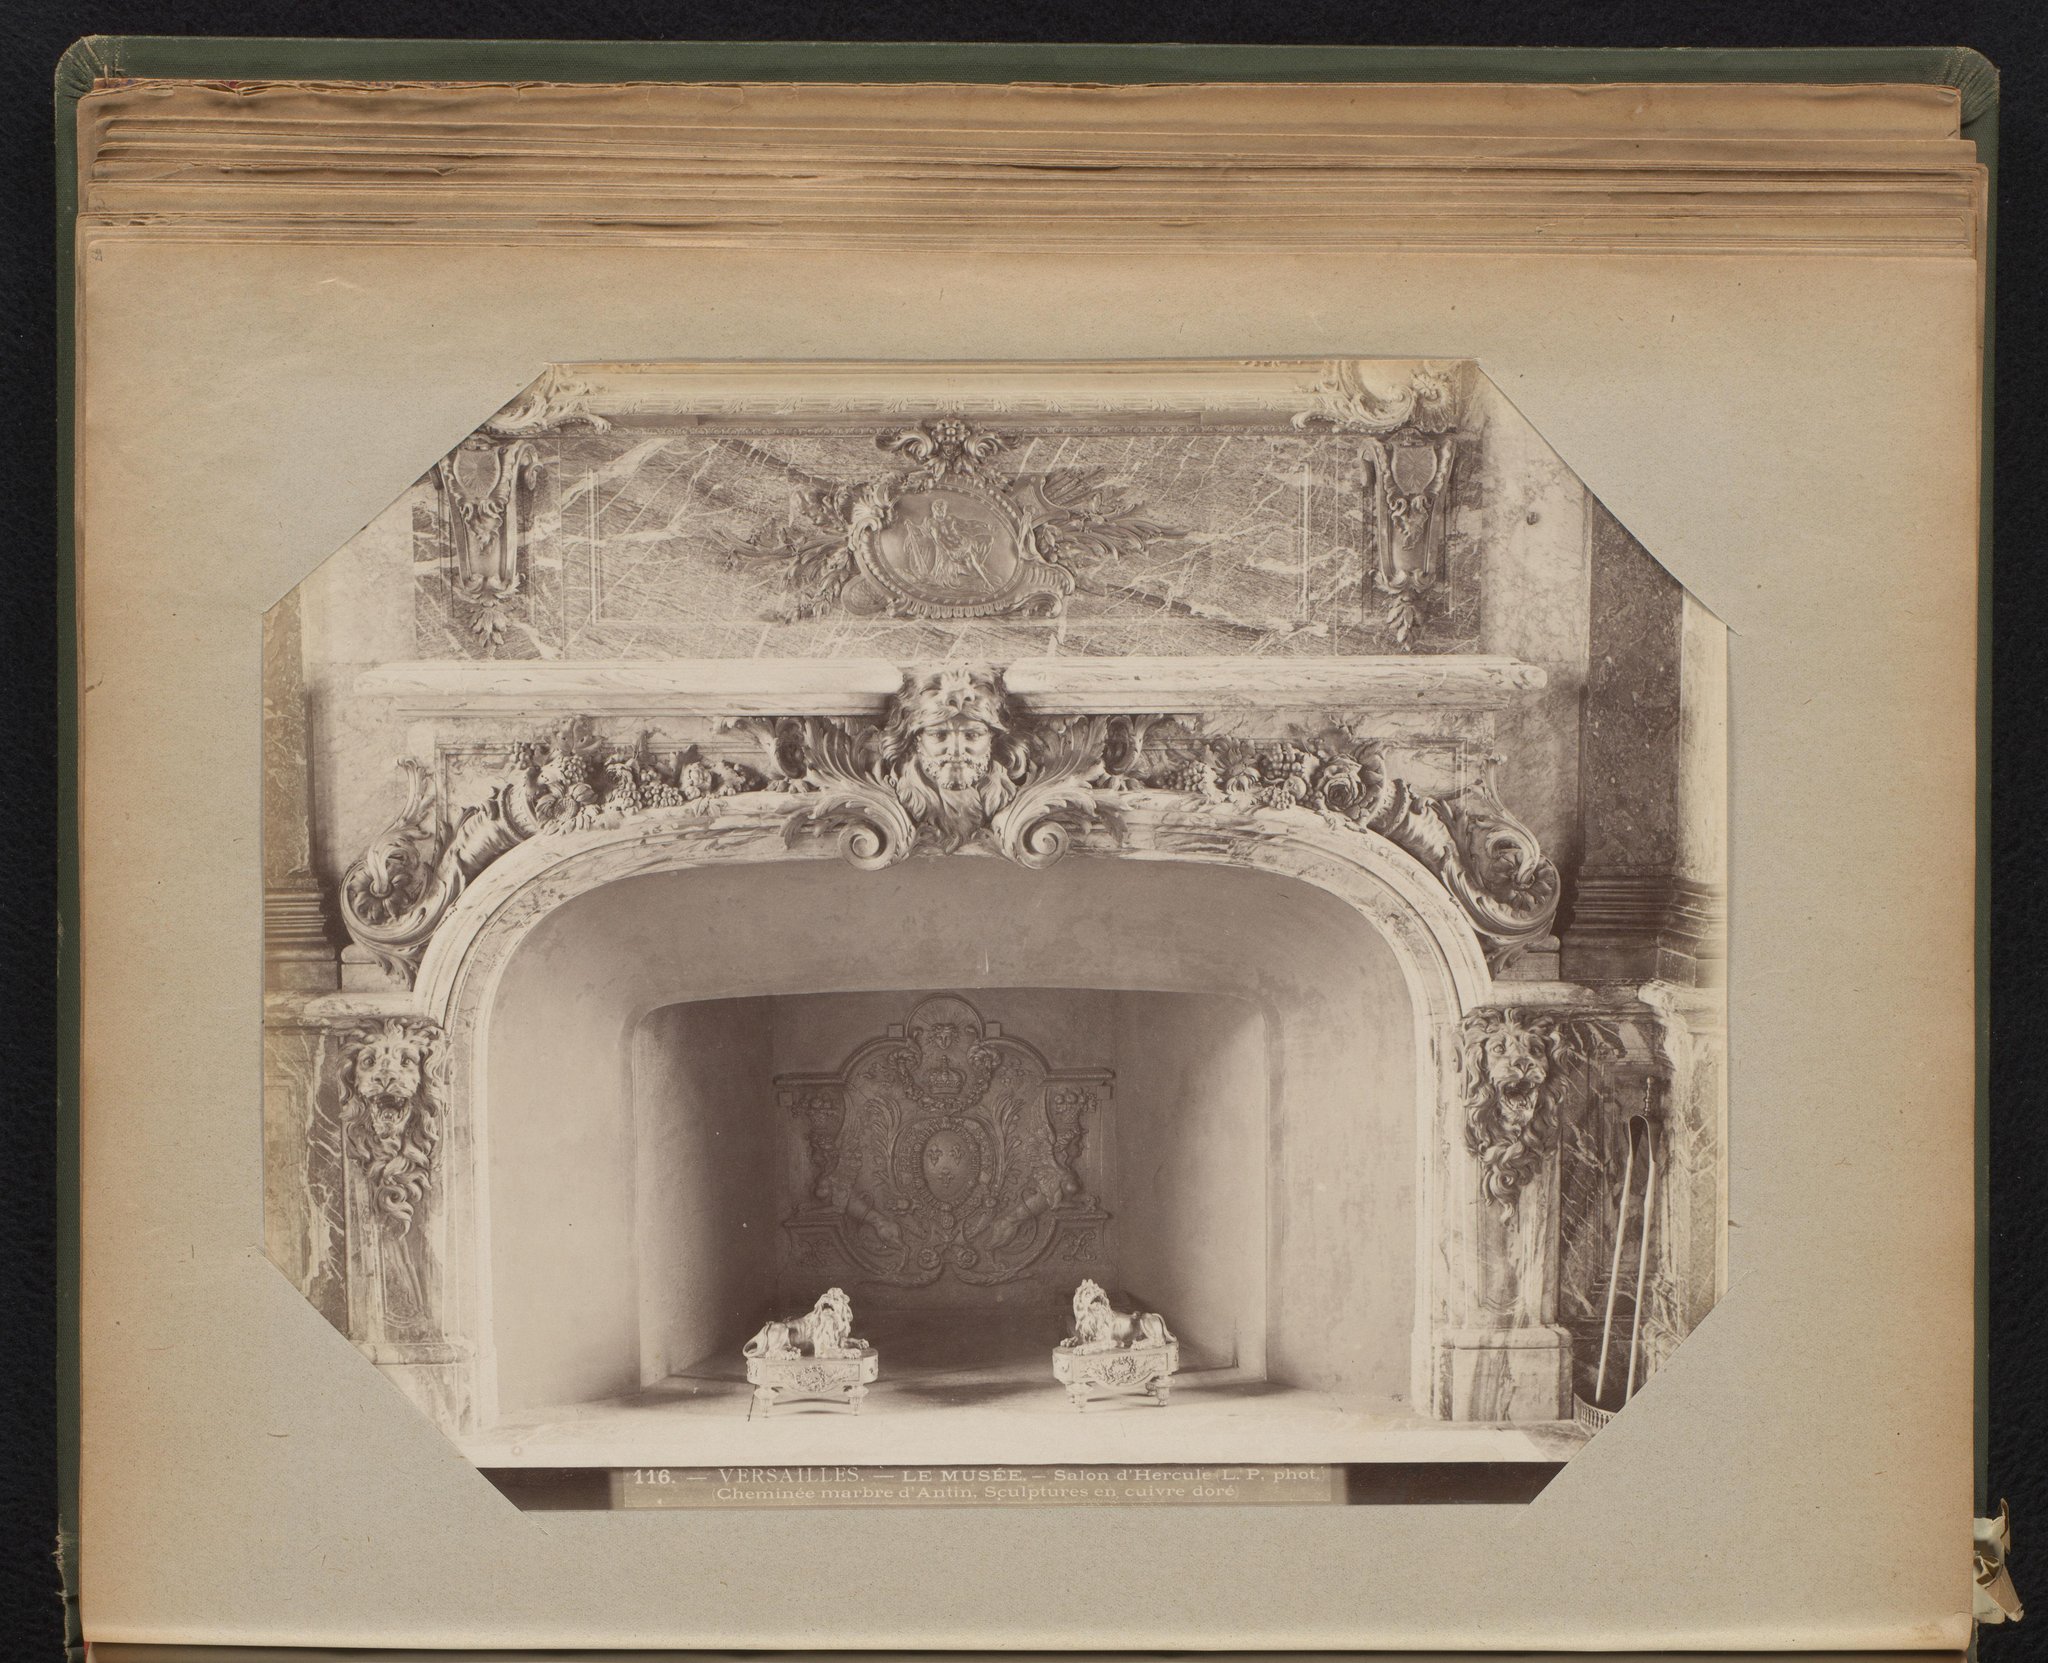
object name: photograph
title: Marmeren schouw versiert met leeuwenkoppen en mensenhoofd in marmer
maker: Anonymous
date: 1860-1900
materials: paper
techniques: albumen print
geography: france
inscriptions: annotation: ‘226 - Versailles - Le Musee - Salon d'Hercule L.P. Phot. (Cheminee marbre d'Antin sculptures en cuivre doré)’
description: Onderdeel van een serie met betrekking tot het interieur van het paleis van Versailles met kroonluchters, deuren, portalen en meubelstukken.